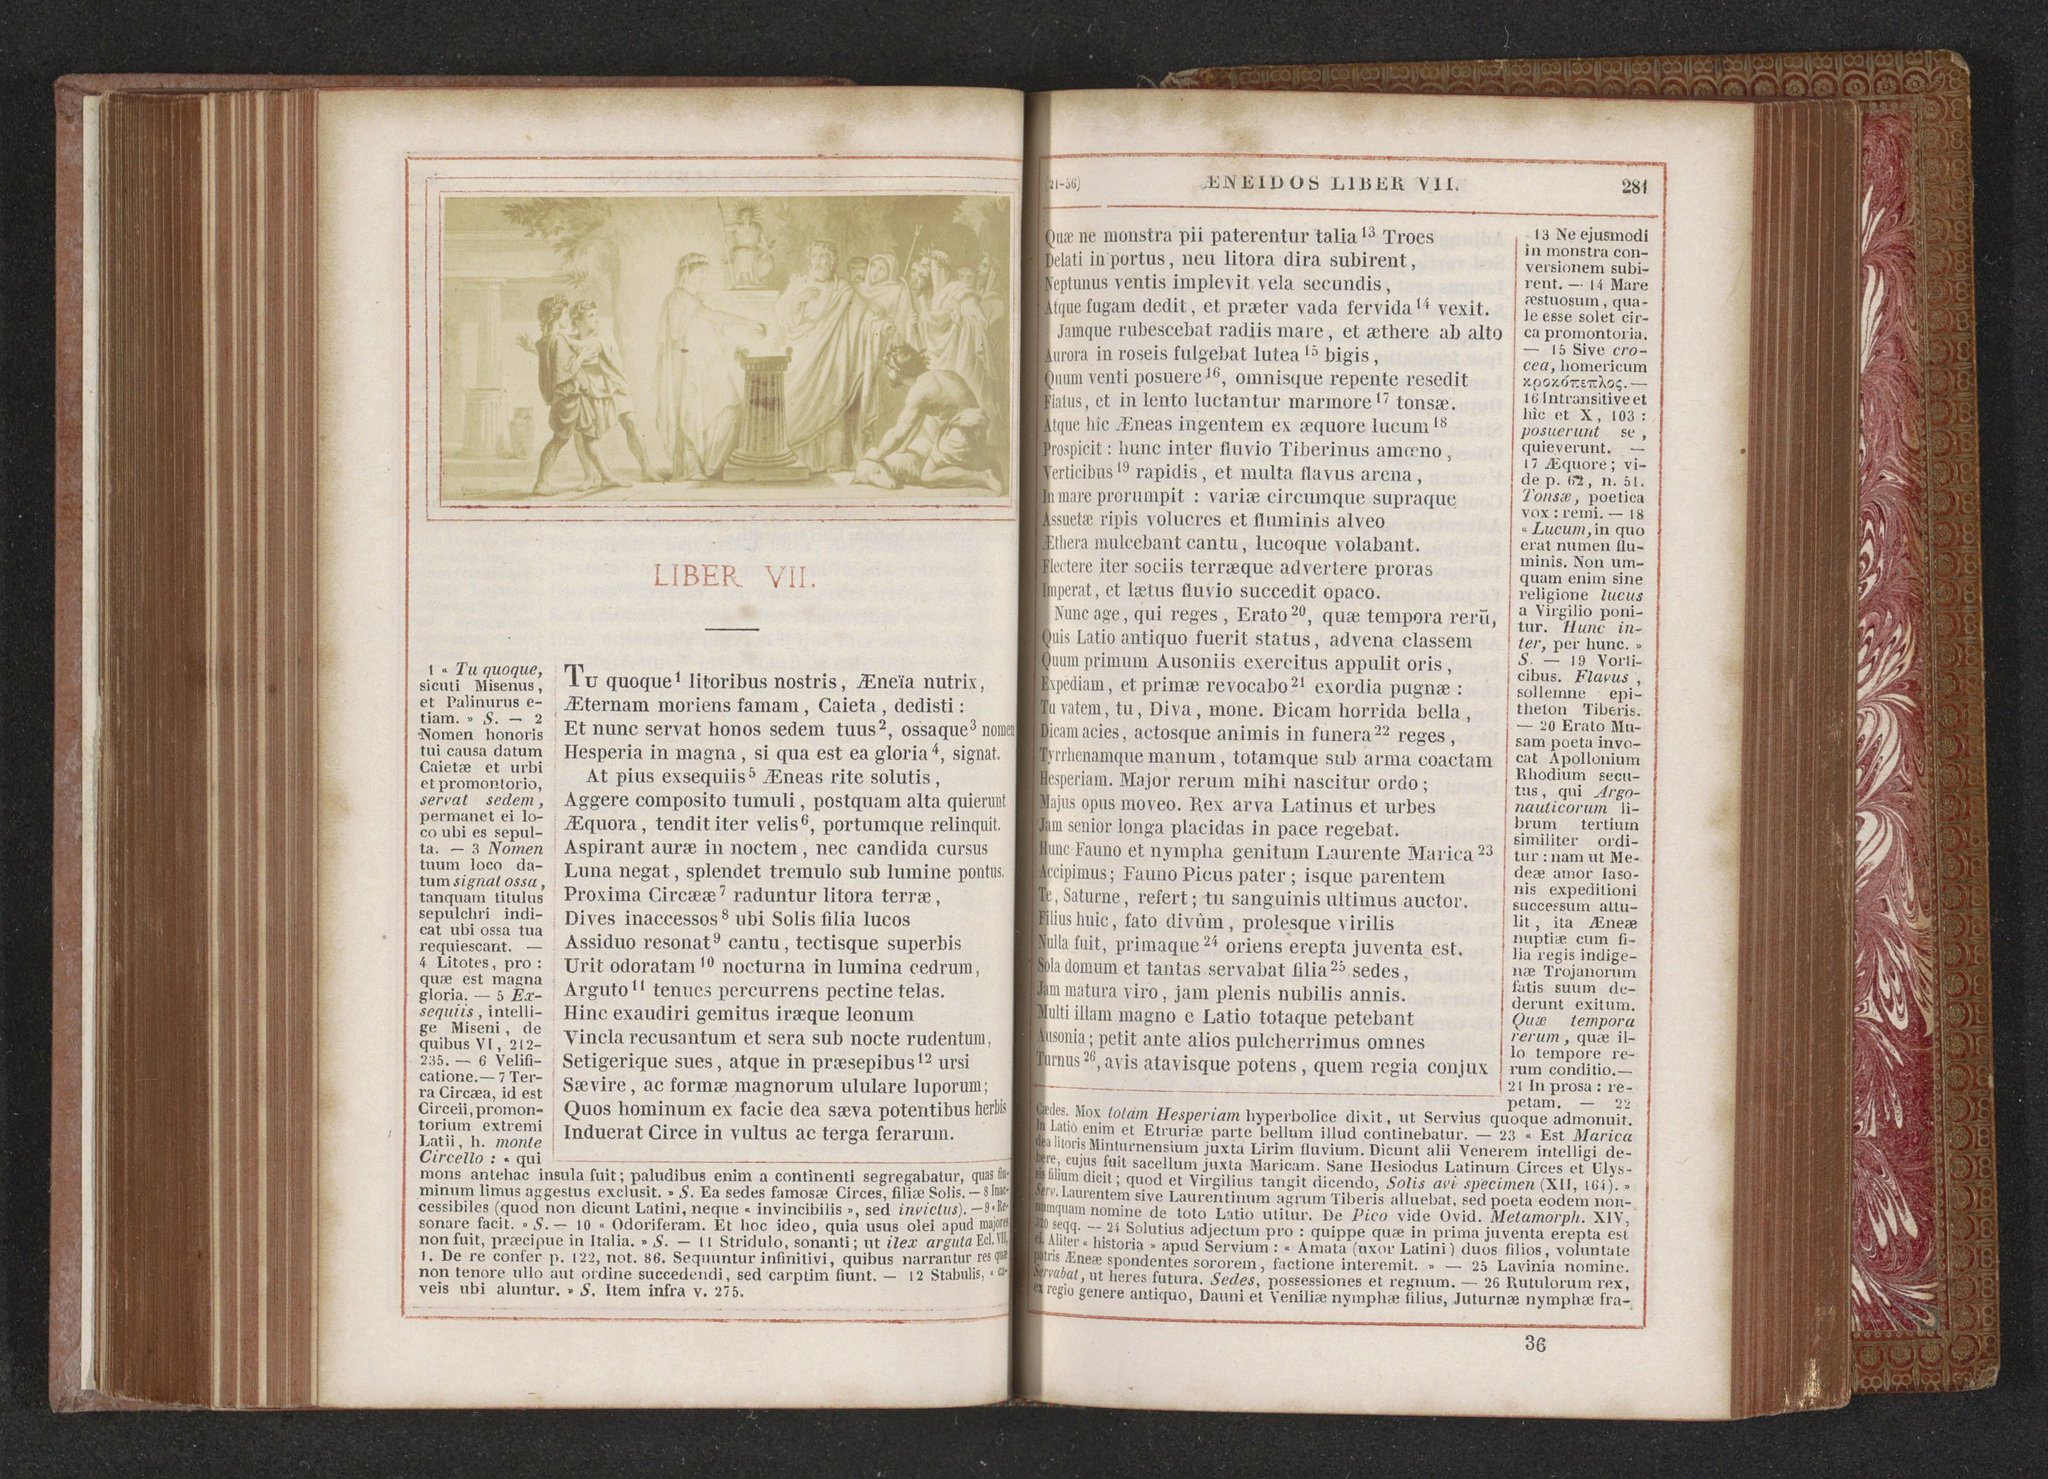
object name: reproduction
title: Fotoreproductie van een schilderij, voorstellende koning Latinus bezoekt het orakel van Faunus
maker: Anonymous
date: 1850-1858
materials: photographic support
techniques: albumen print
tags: latinus consults the oracle of faunus